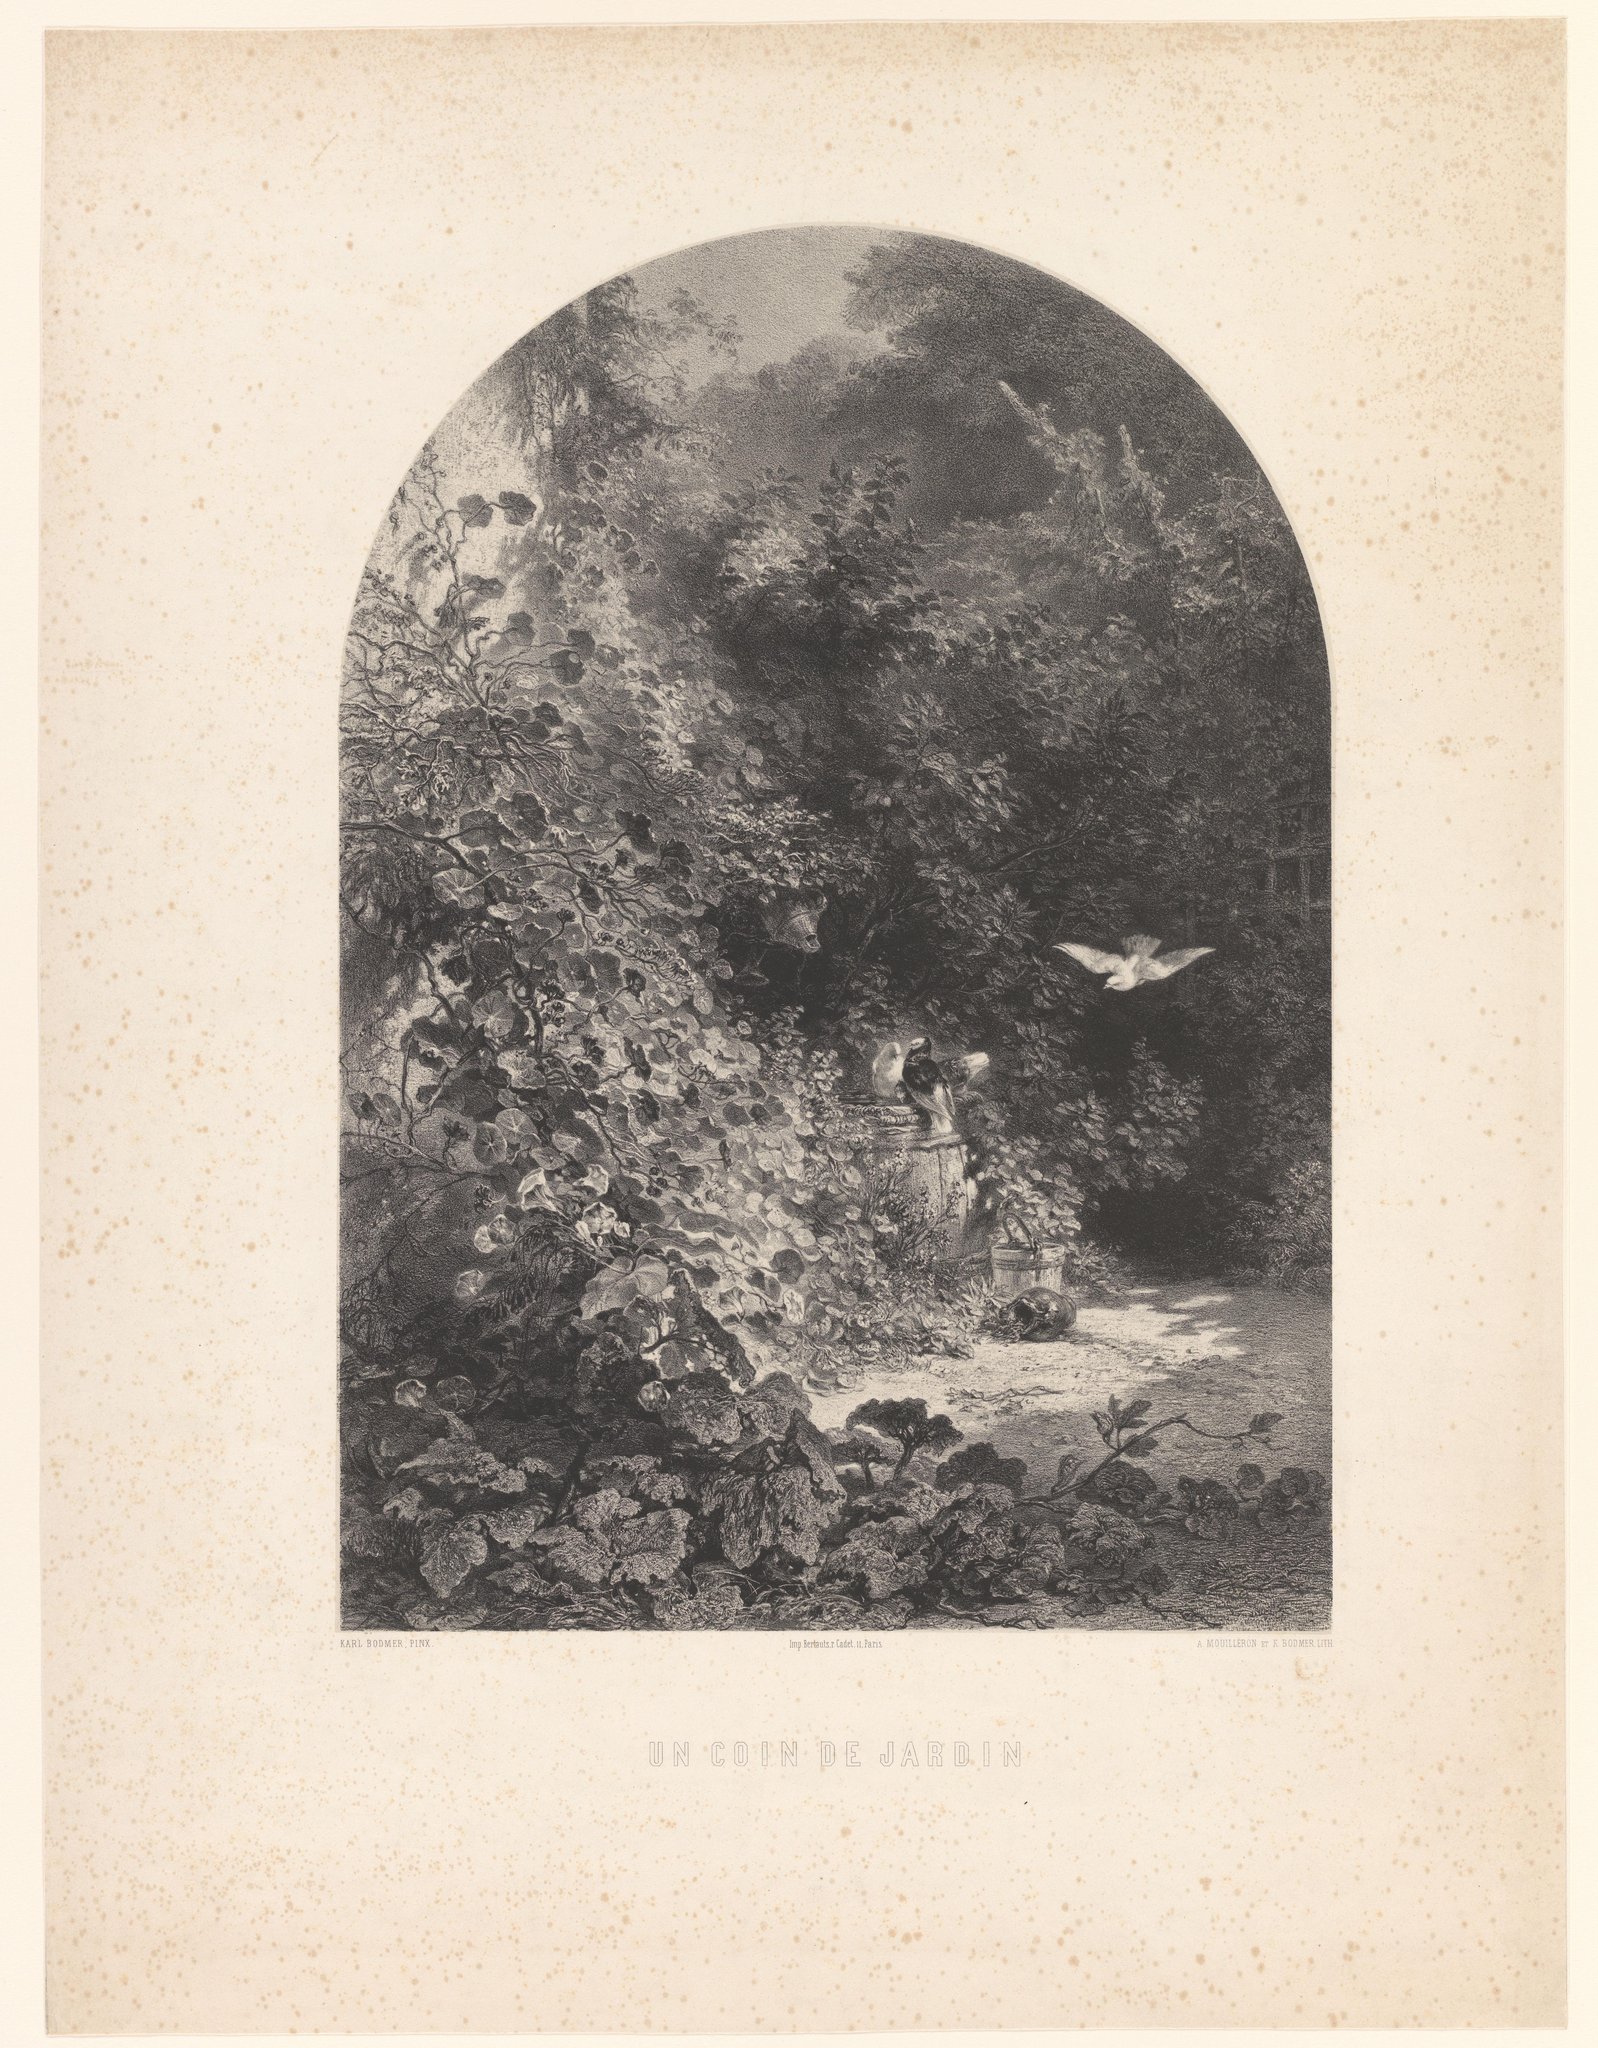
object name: print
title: Un coin de jardin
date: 1830-1852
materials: paper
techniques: lithograph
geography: paris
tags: garden, doves, pigeons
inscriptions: collector's mark: Lugt 2228, check stamp